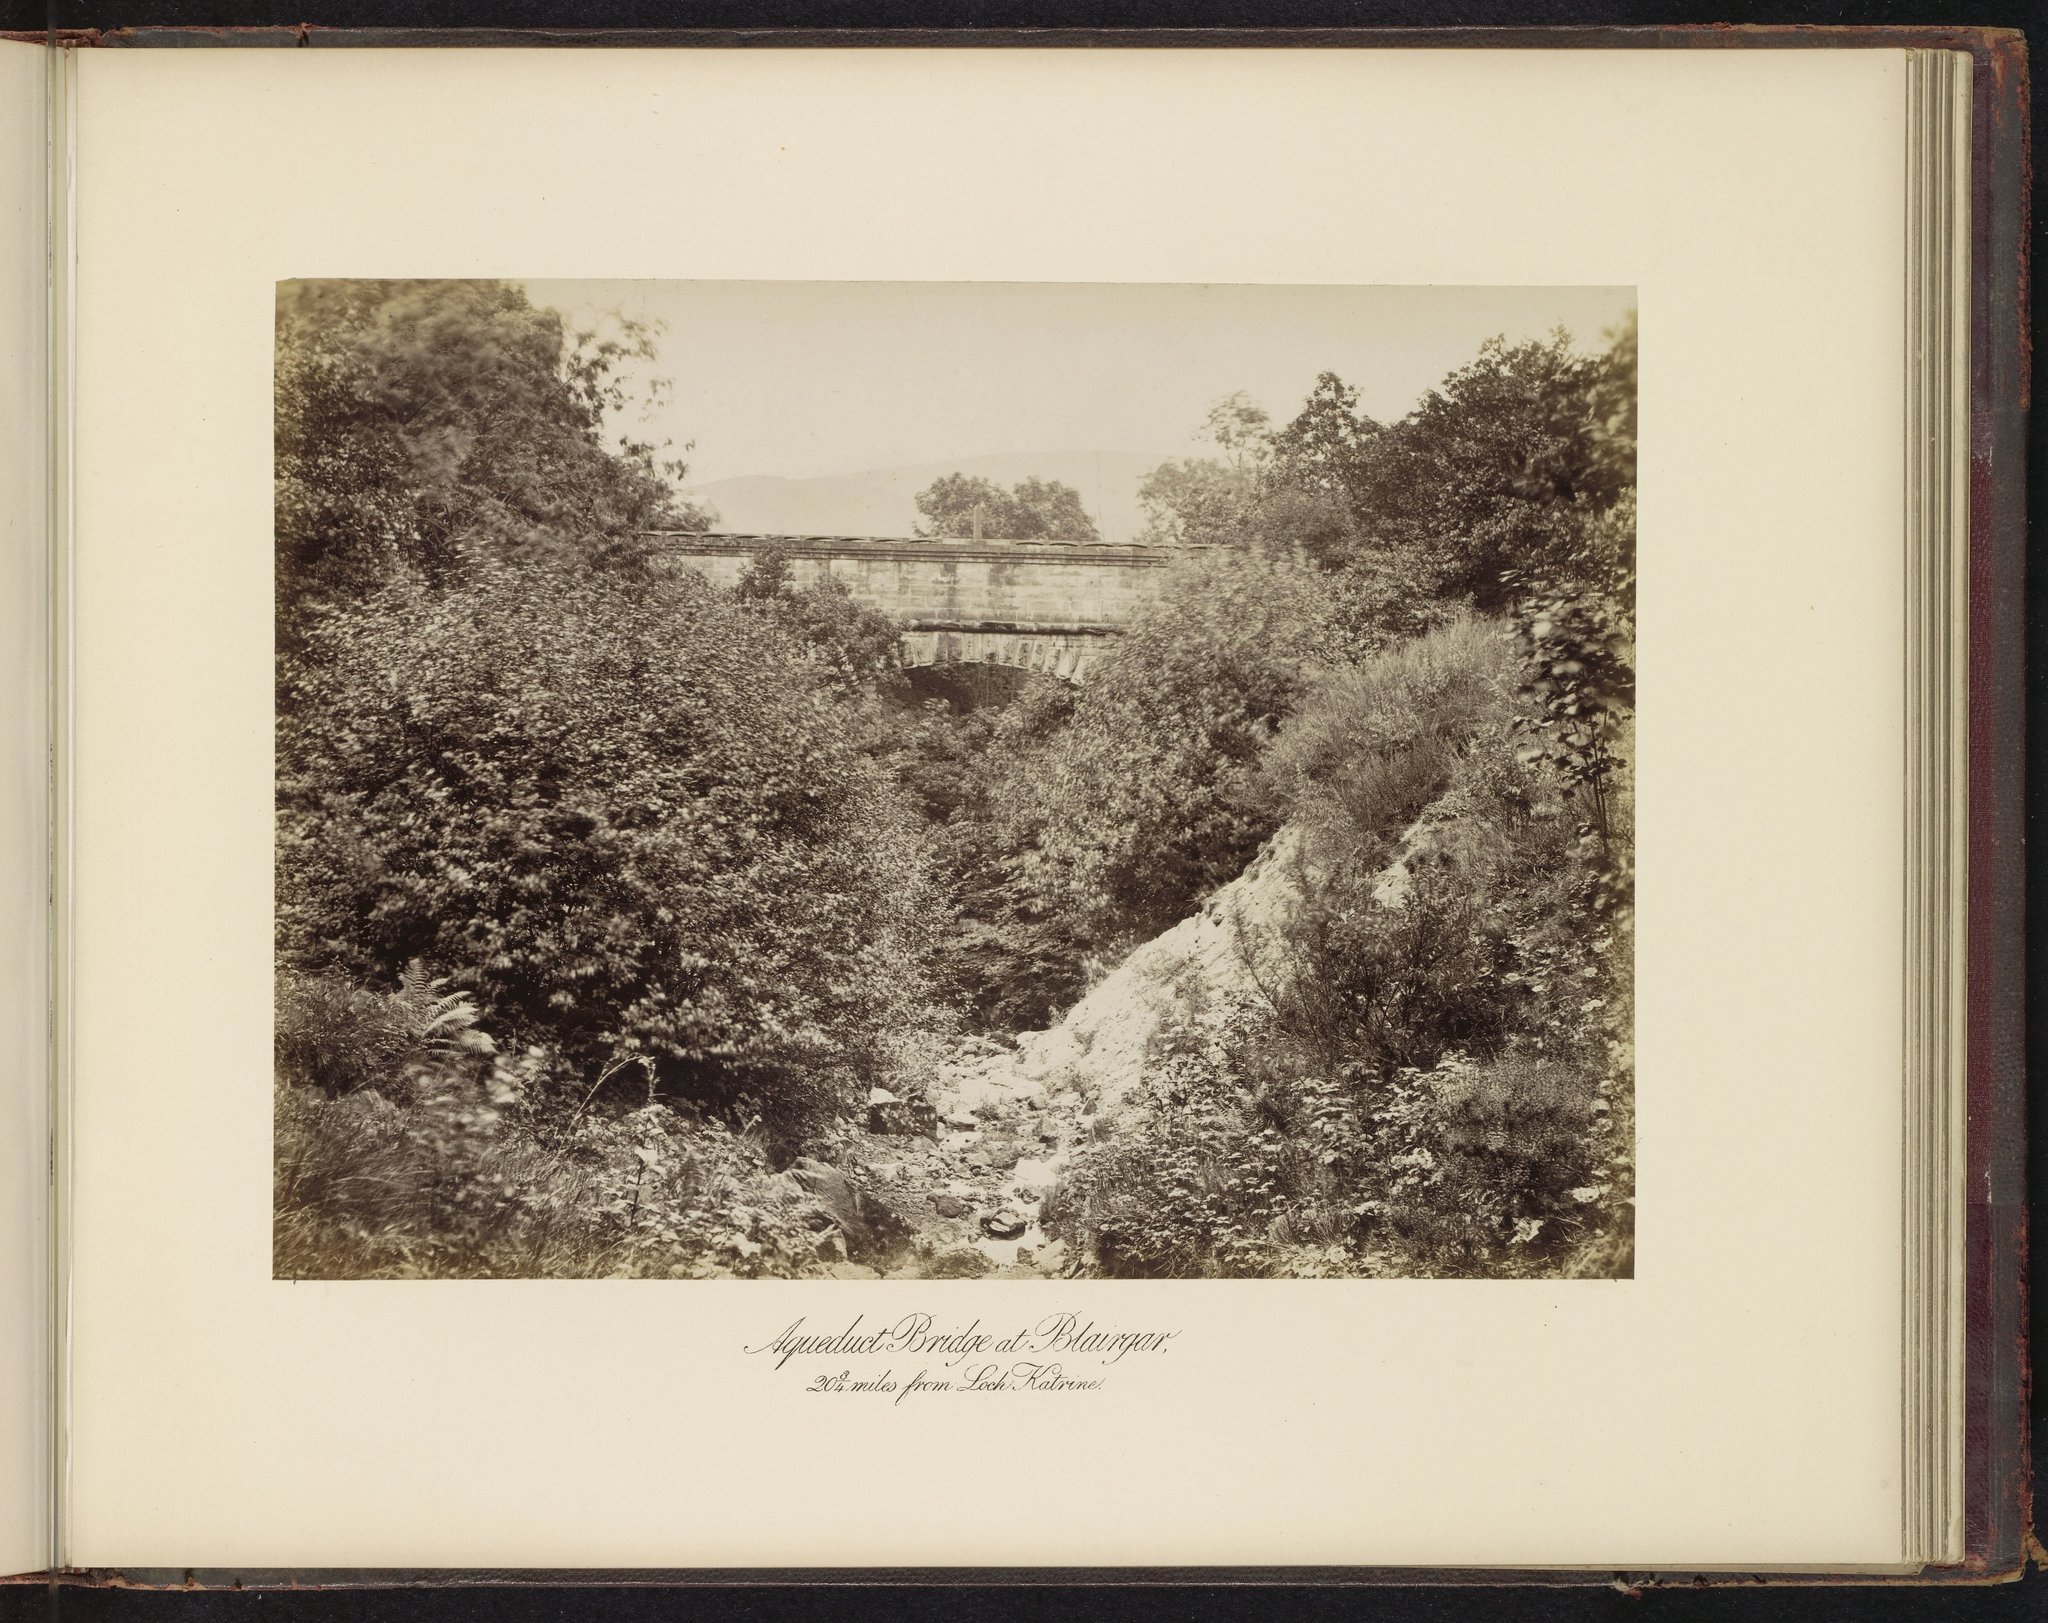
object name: photograph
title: Aqueduct Bridge at Blairgar, 20 3/4 miles from Loch Katrine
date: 1879-1889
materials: photographic support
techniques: albumen print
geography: stirling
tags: dale, valley, aqueduct (~ water supply)